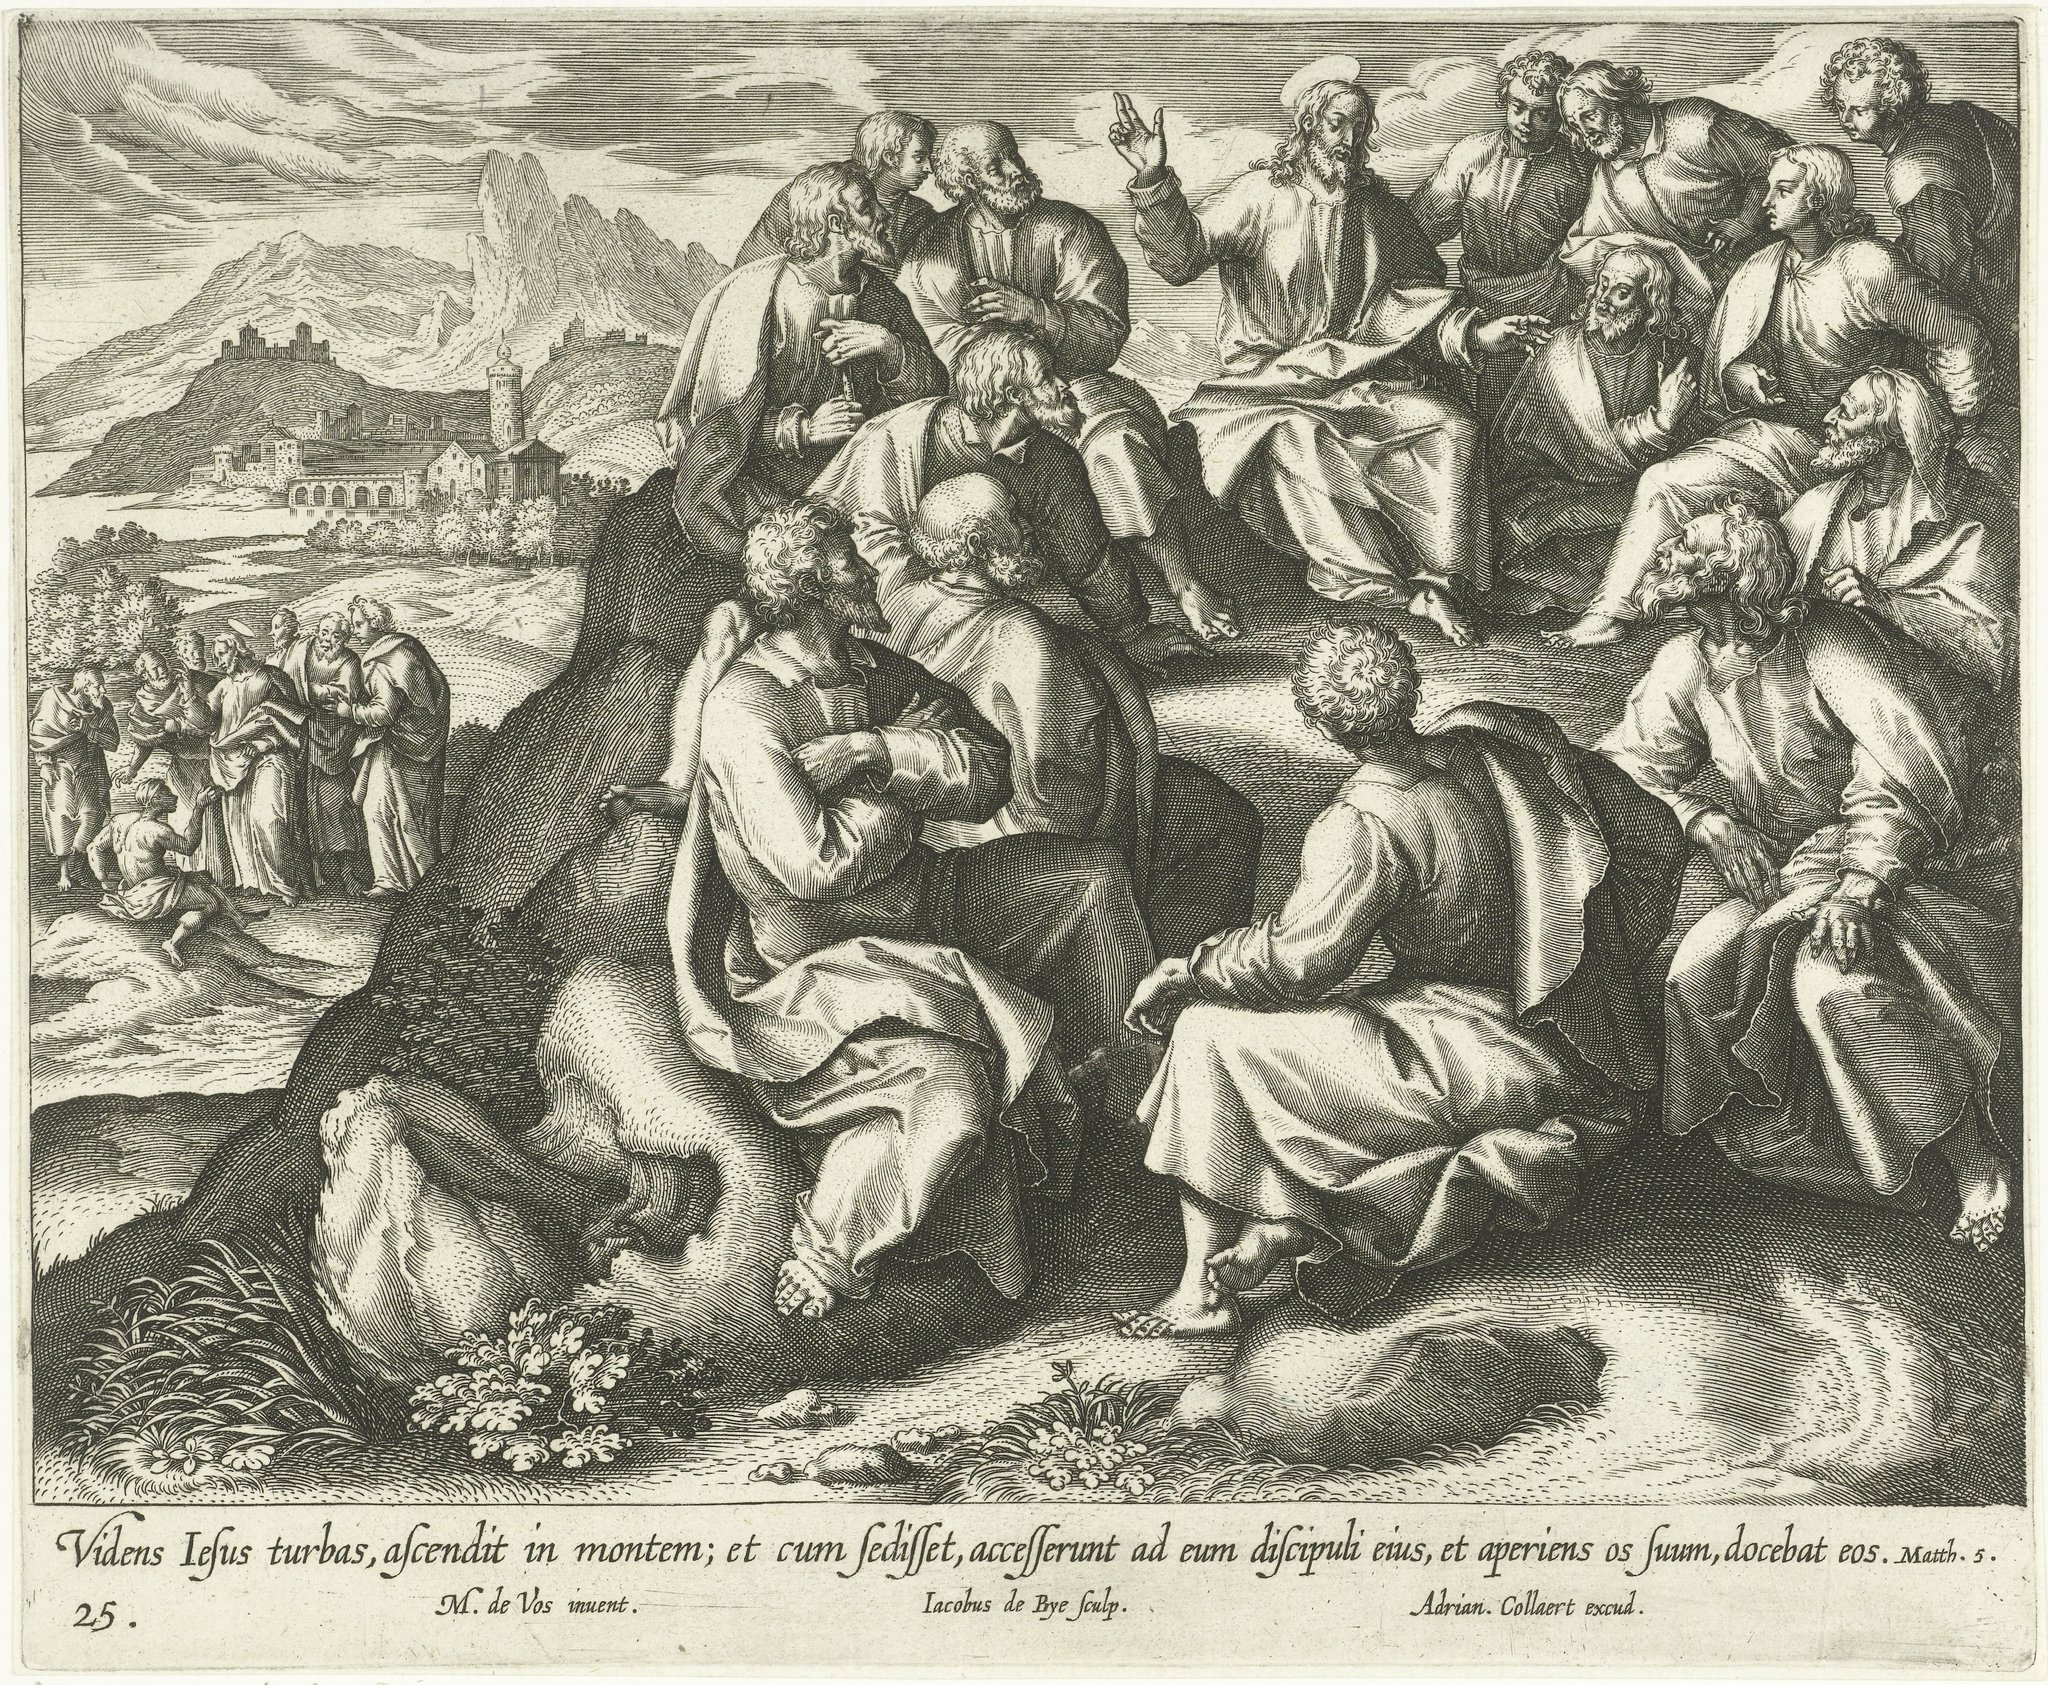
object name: print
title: Bergrede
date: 1598-1618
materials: paper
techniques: engraving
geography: antwerp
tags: beatitudes of the sermon on the mount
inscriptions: collector's mark: Lugt 2228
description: Christus zit op de top van een berg, zijn leerlingen luisterend rondom hem. De leer van Christus wordt uiteengezet (Matteüs 5:1-12). De prent heeft een Latijns onderschrift. De prent maakt deel uit van een serie over het leven van Christus.